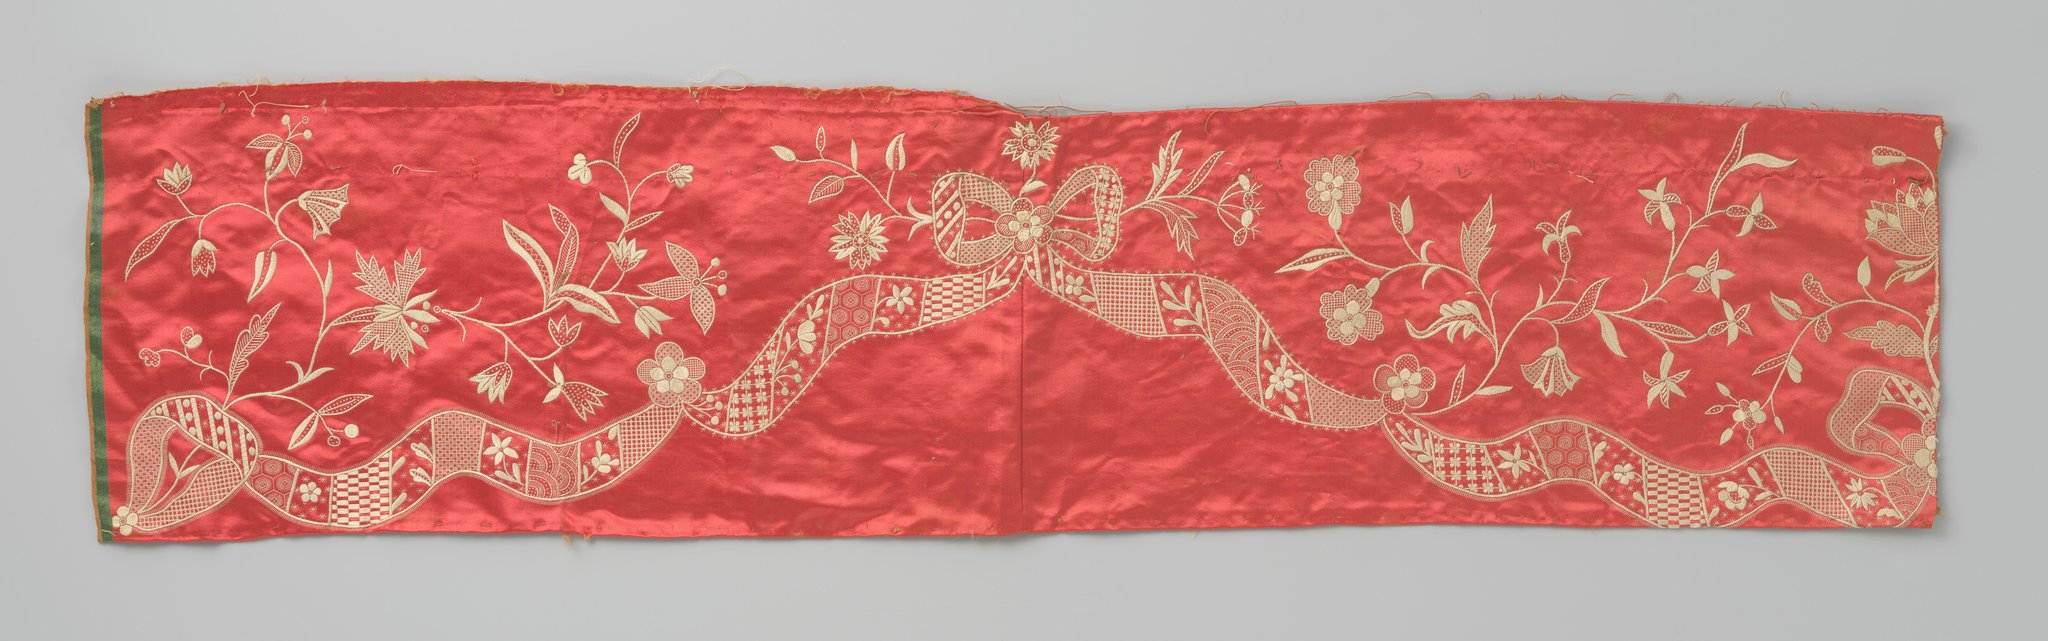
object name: strip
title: Embroidered Interior Textile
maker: Anonymous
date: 1750-1760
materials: silk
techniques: embroidered, weave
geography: france